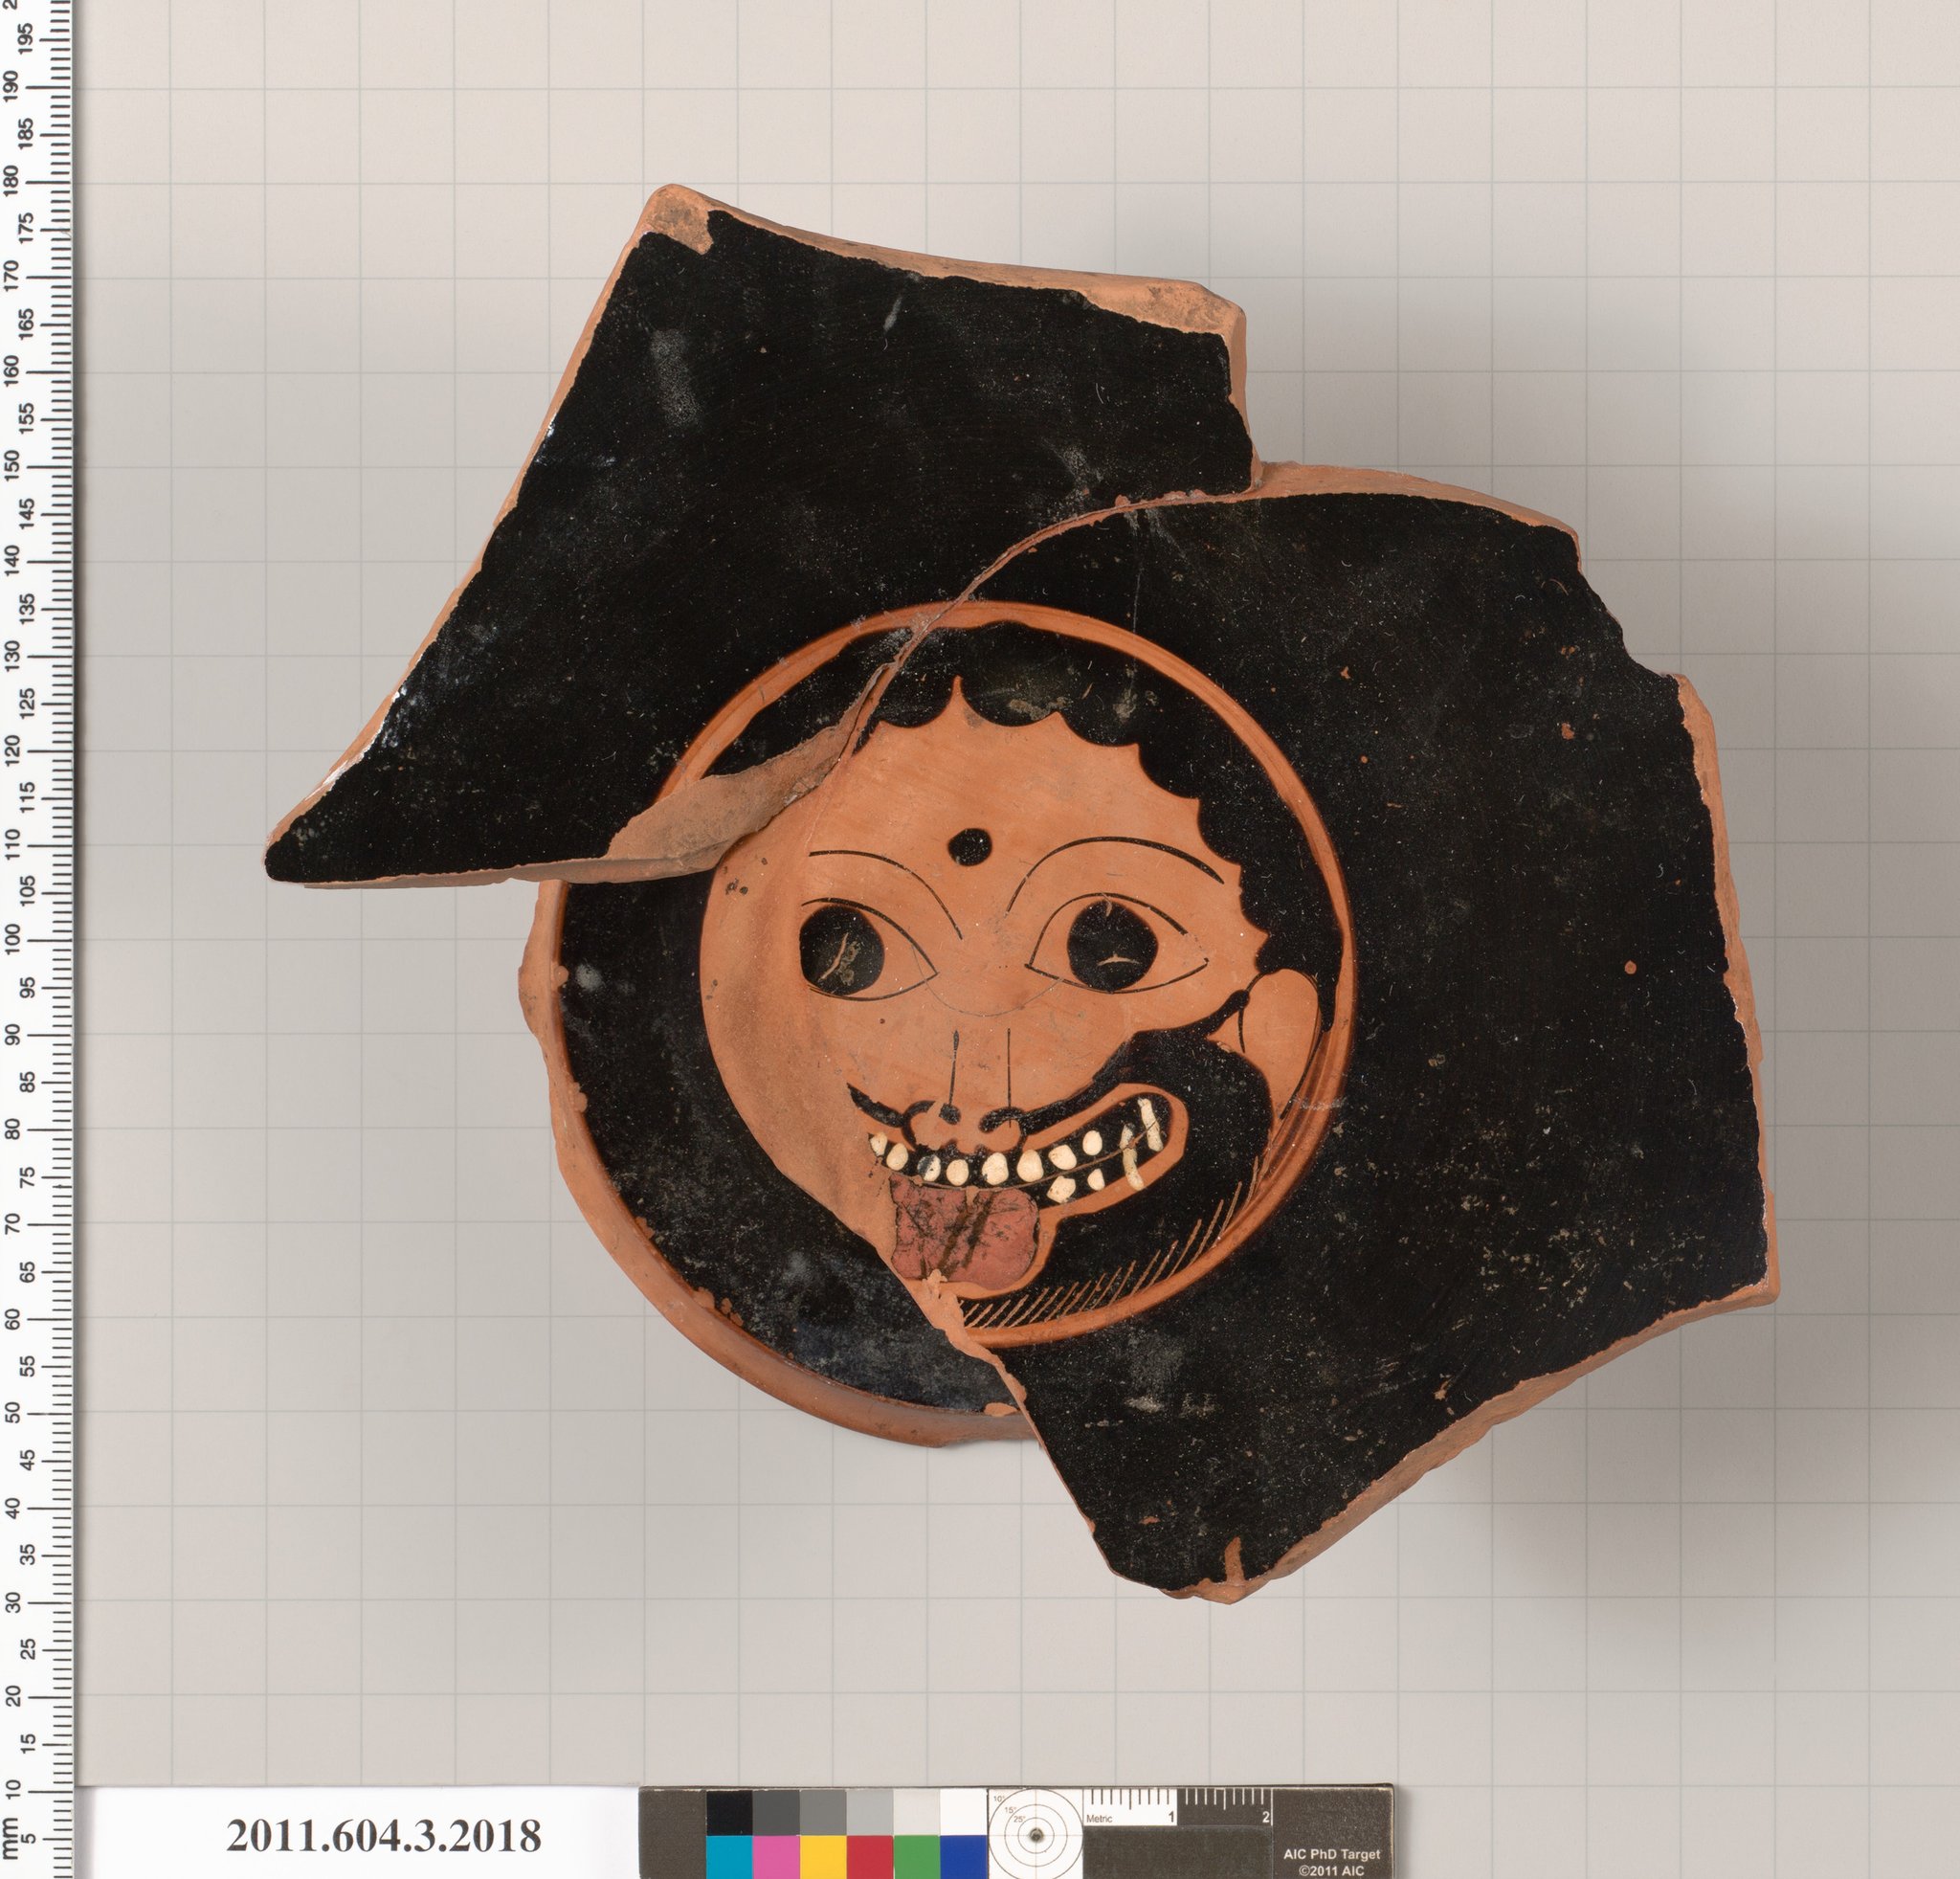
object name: kylix fragment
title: Terracotta fragment of a kylix: eye-cup (drinking cup)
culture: greek, attic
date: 550-526 BCE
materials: terracotta